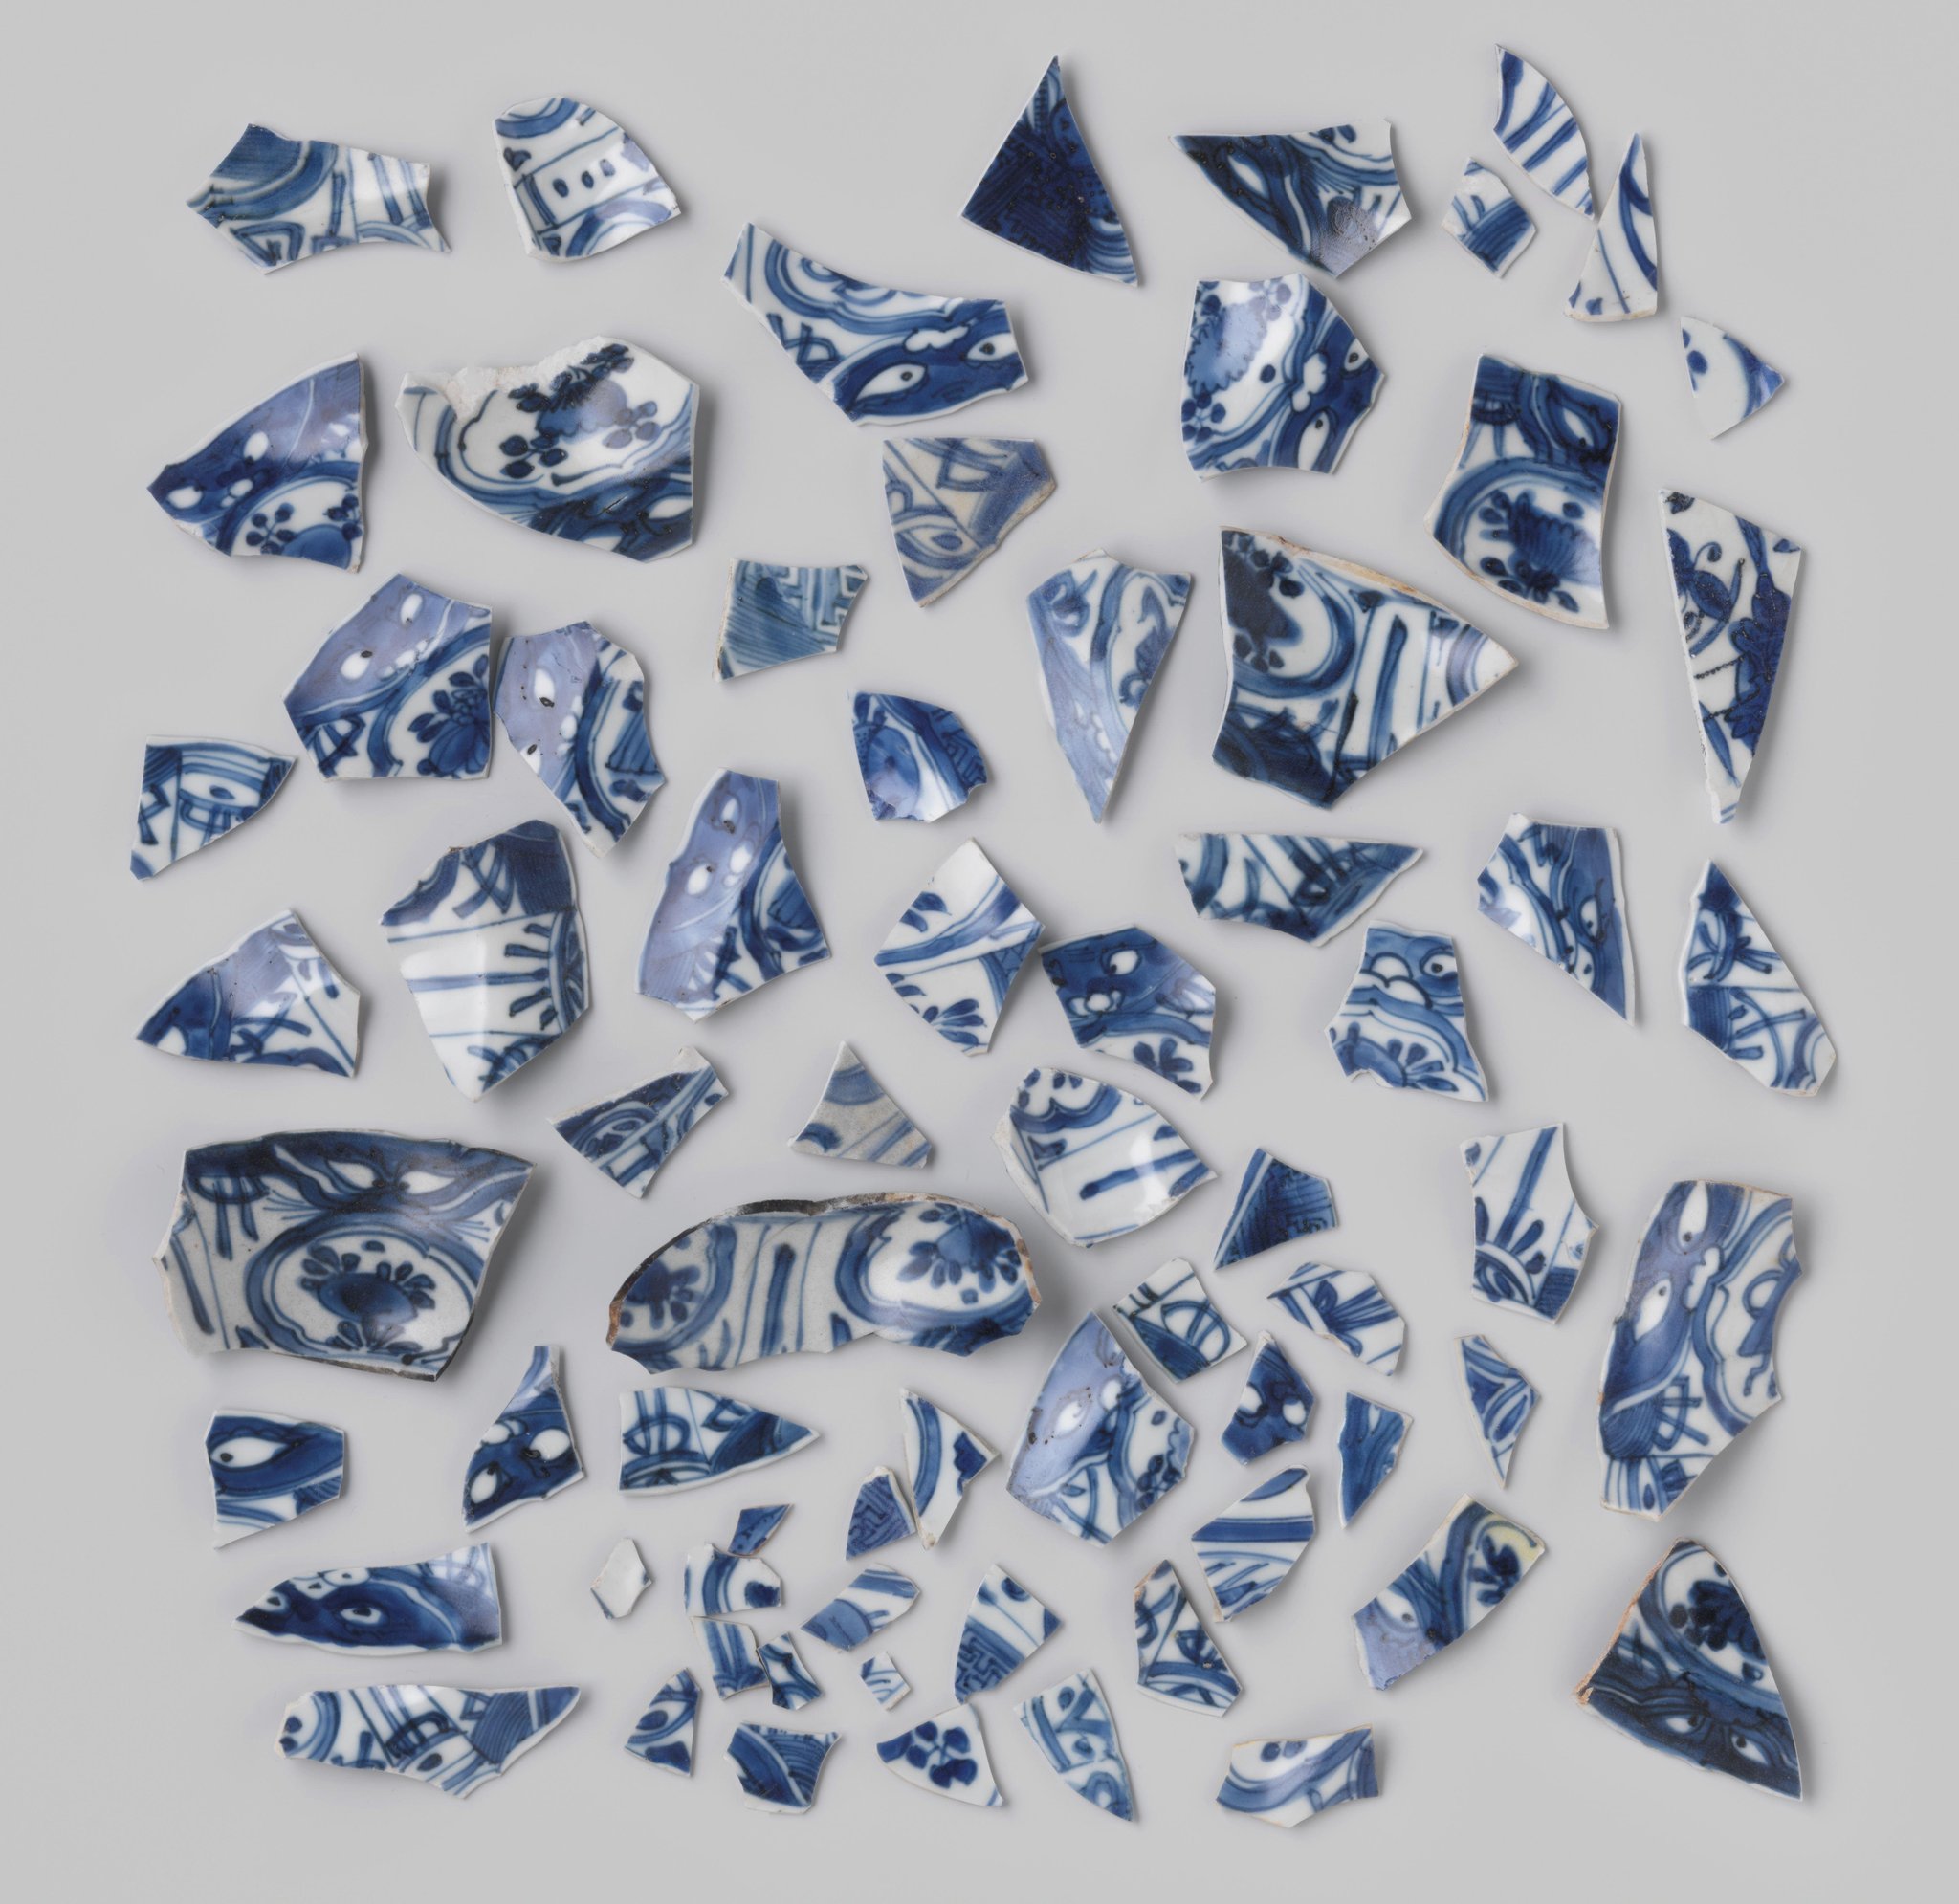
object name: sherd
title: Scherven van borden uit V.O.C.-schip de 'Witte Leeuw'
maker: Anonymous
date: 1613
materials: bone china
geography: jingdezhen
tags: verenigde oostindische compagnie, sint-helena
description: Scherven van borden uit V.O.C.-schip de 'Witte Leeuw'.